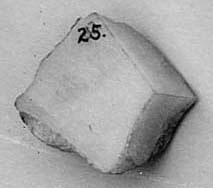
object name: fragment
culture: burmese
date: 1902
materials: jade